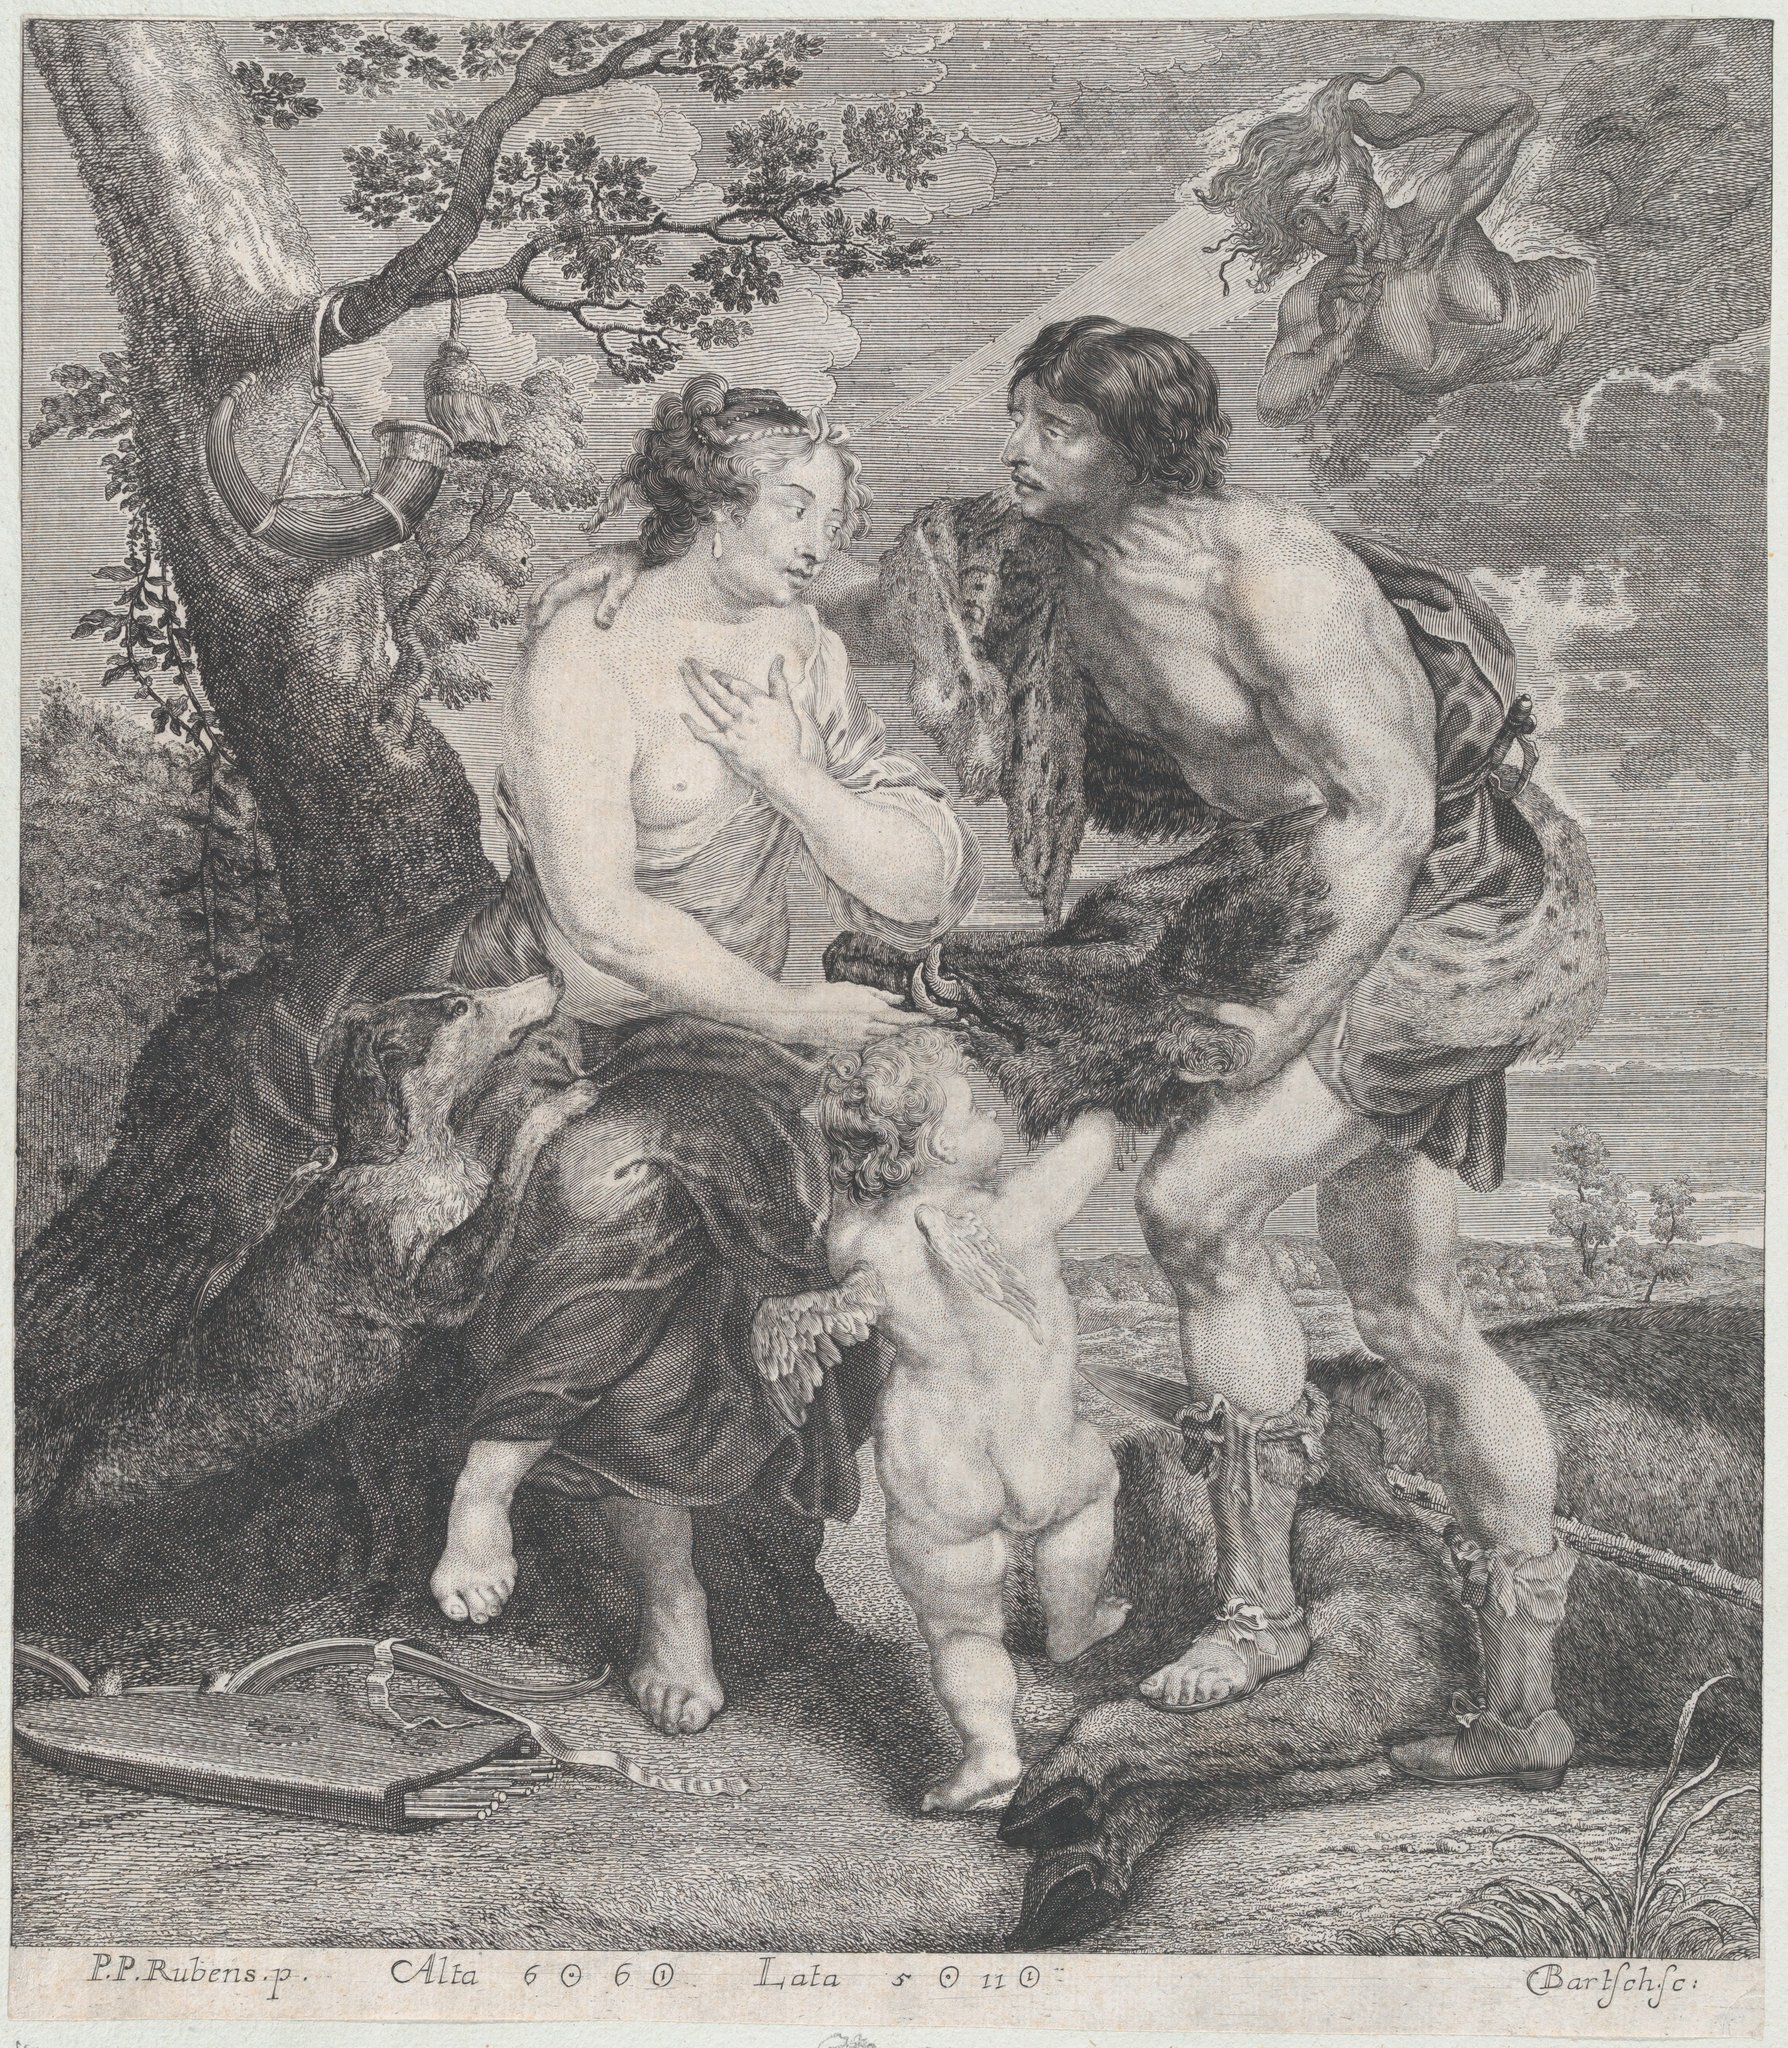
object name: print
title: Atalanta and Meleager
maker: johann gottfried bartsch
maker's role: artist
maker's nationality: german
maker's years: 1620-1720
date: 1670-1690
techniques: etching